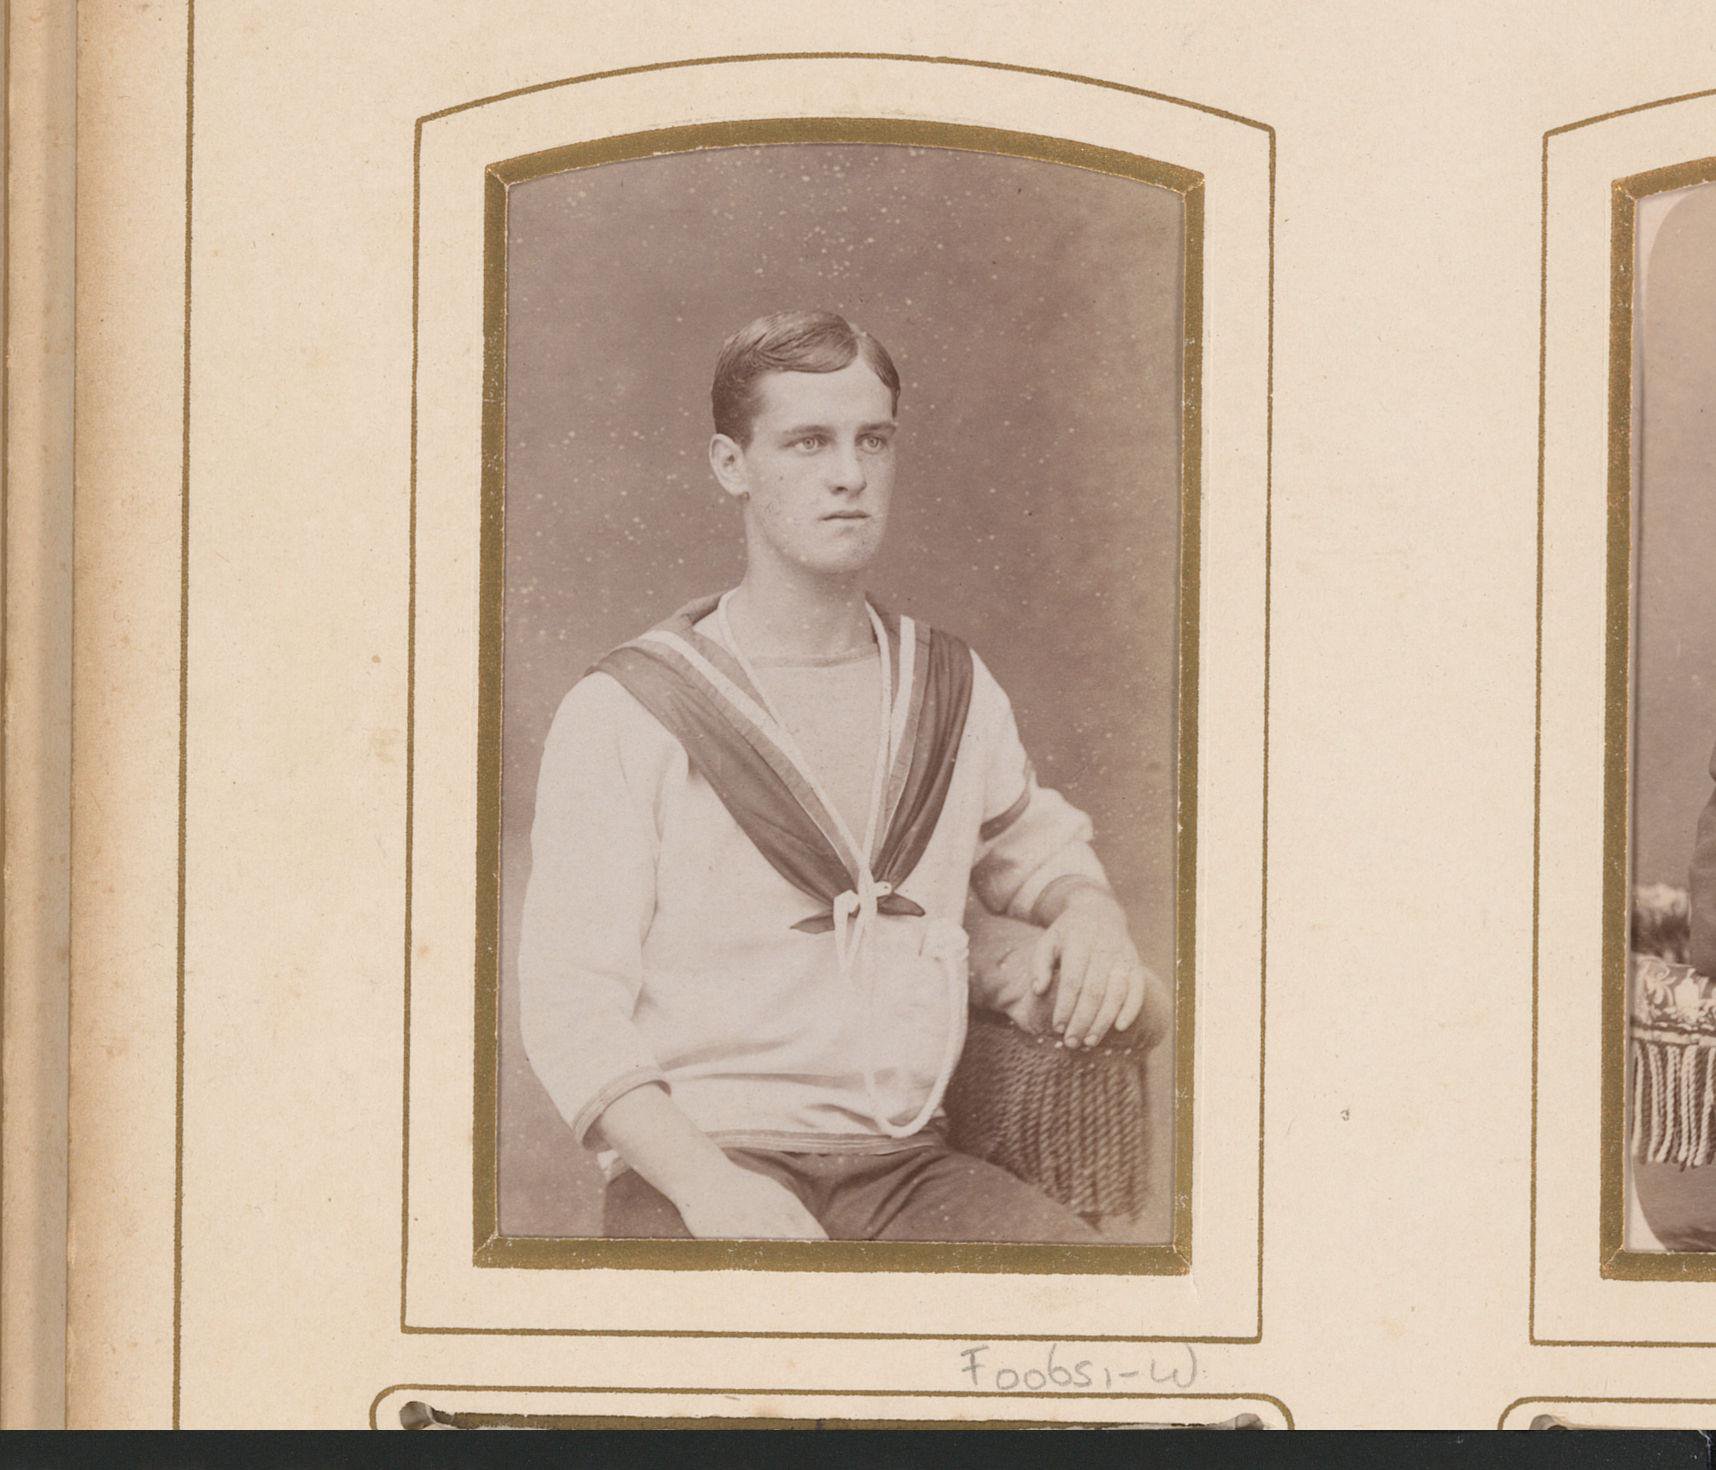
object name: album leaf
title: Portret van een matroos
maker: h.j. davison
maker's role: fotograaf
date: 1880-1915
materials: cardboard, photographic support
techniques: albumen print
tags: adult man, historical persons, seaman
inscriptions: inscription: ‘Strada reale 57 Valletta, Malta’